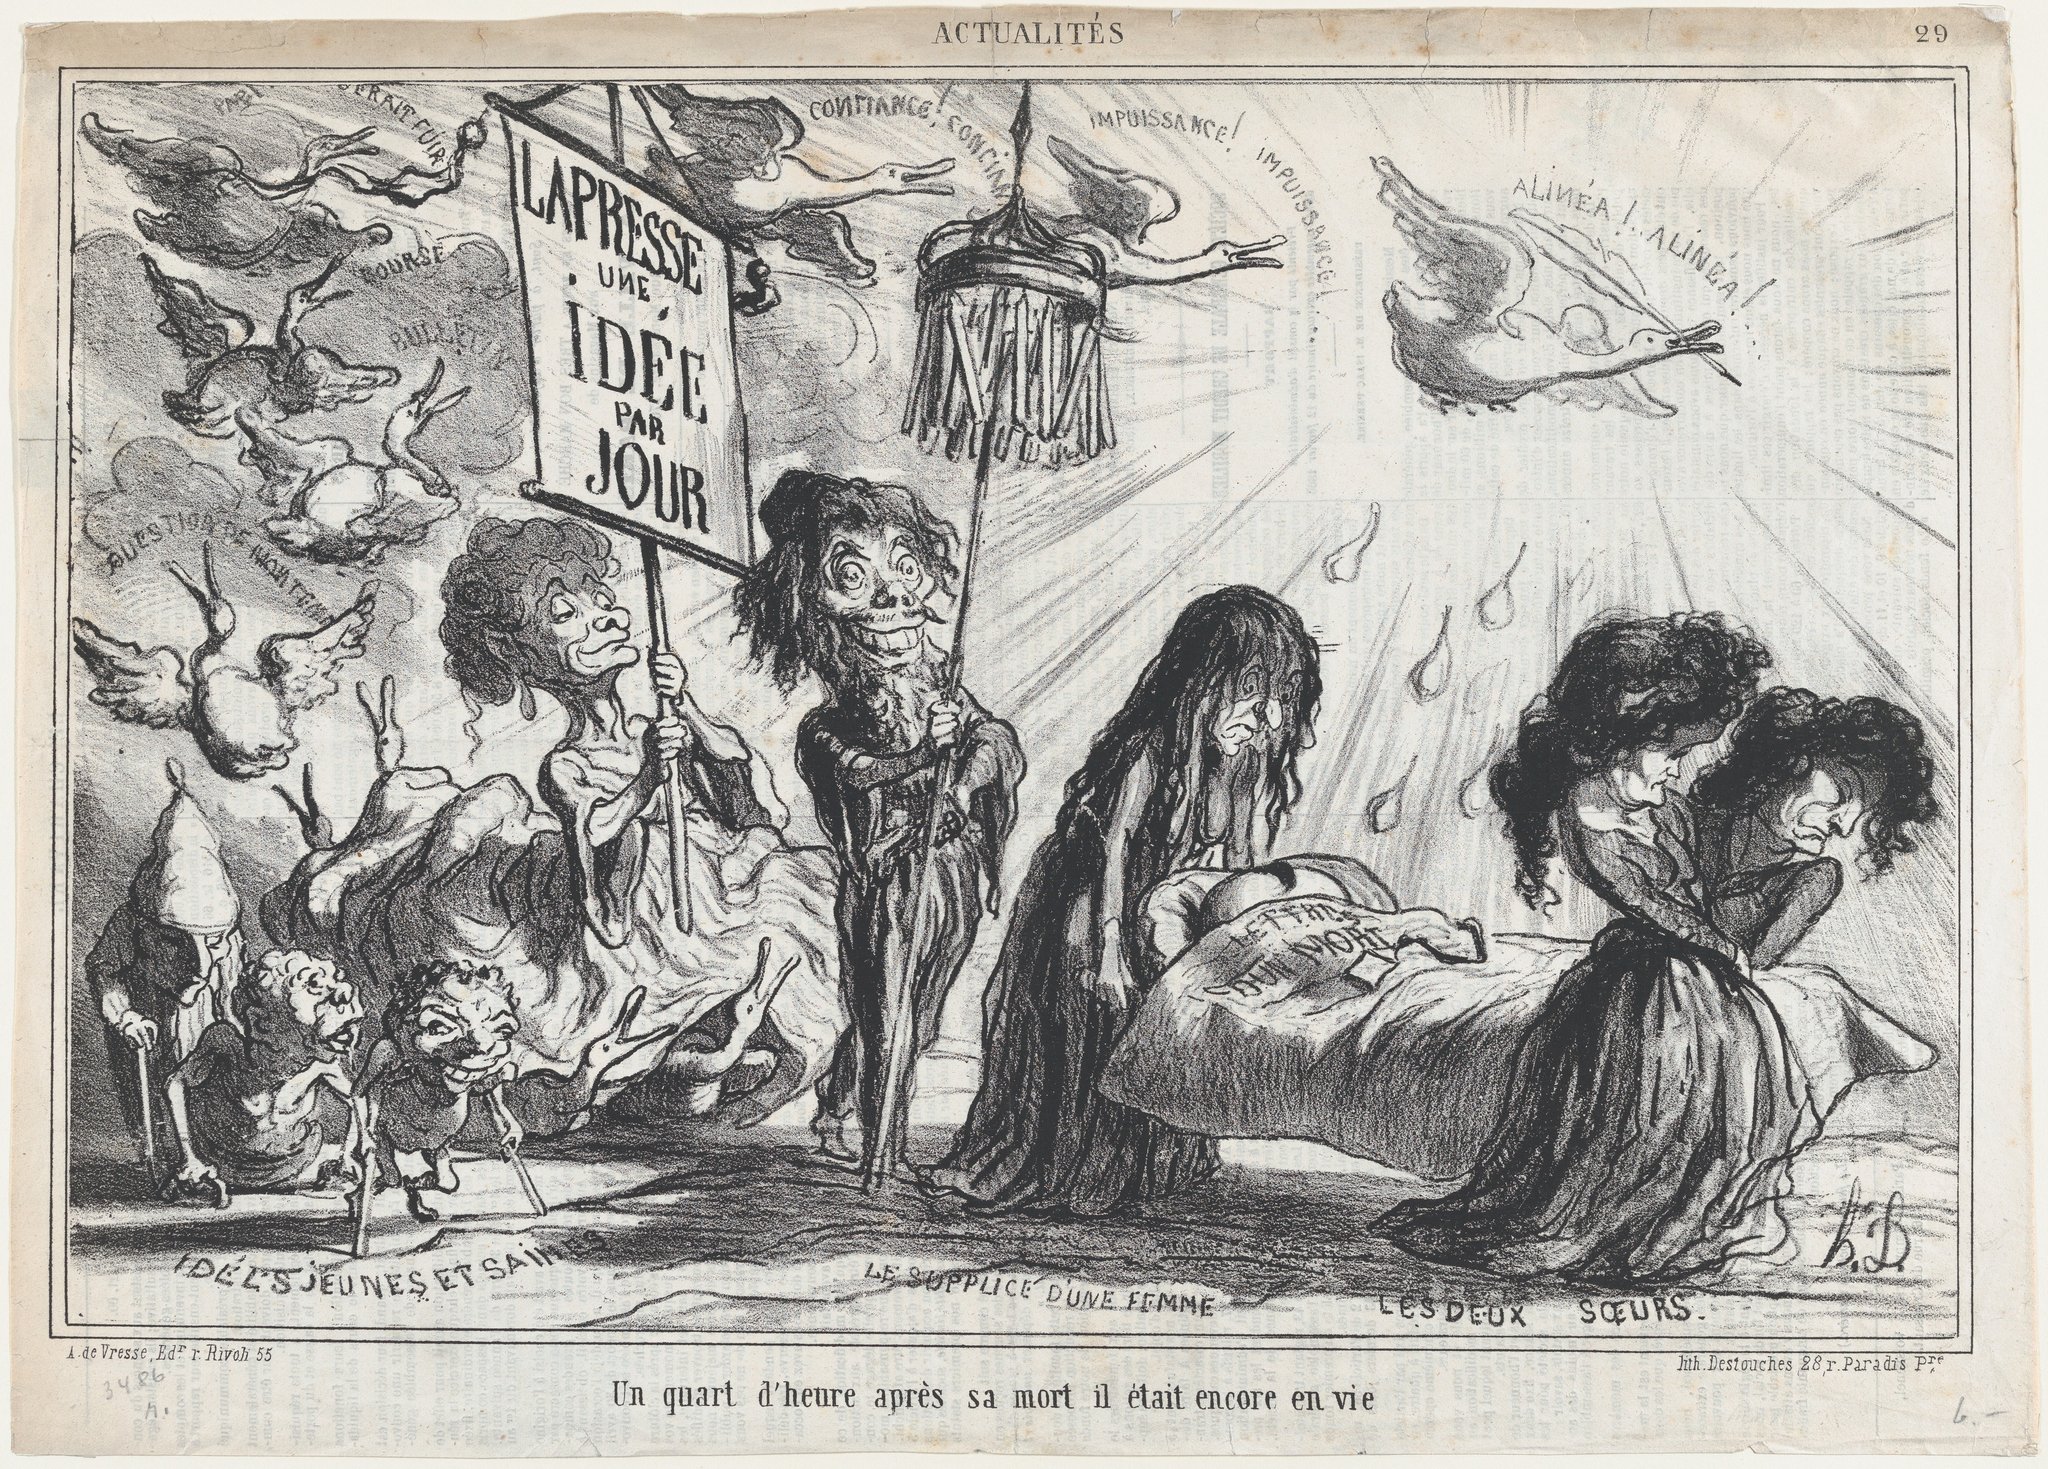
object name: print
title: A quarter of an hour after his death, he was still living, from 'News of the day,' published in Le Charivari, February 20, 1866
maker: honoré daumier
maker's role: artist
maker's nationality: french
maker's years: 1808-1879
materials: paper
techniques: lithograph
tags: birds,satire,men,women,death